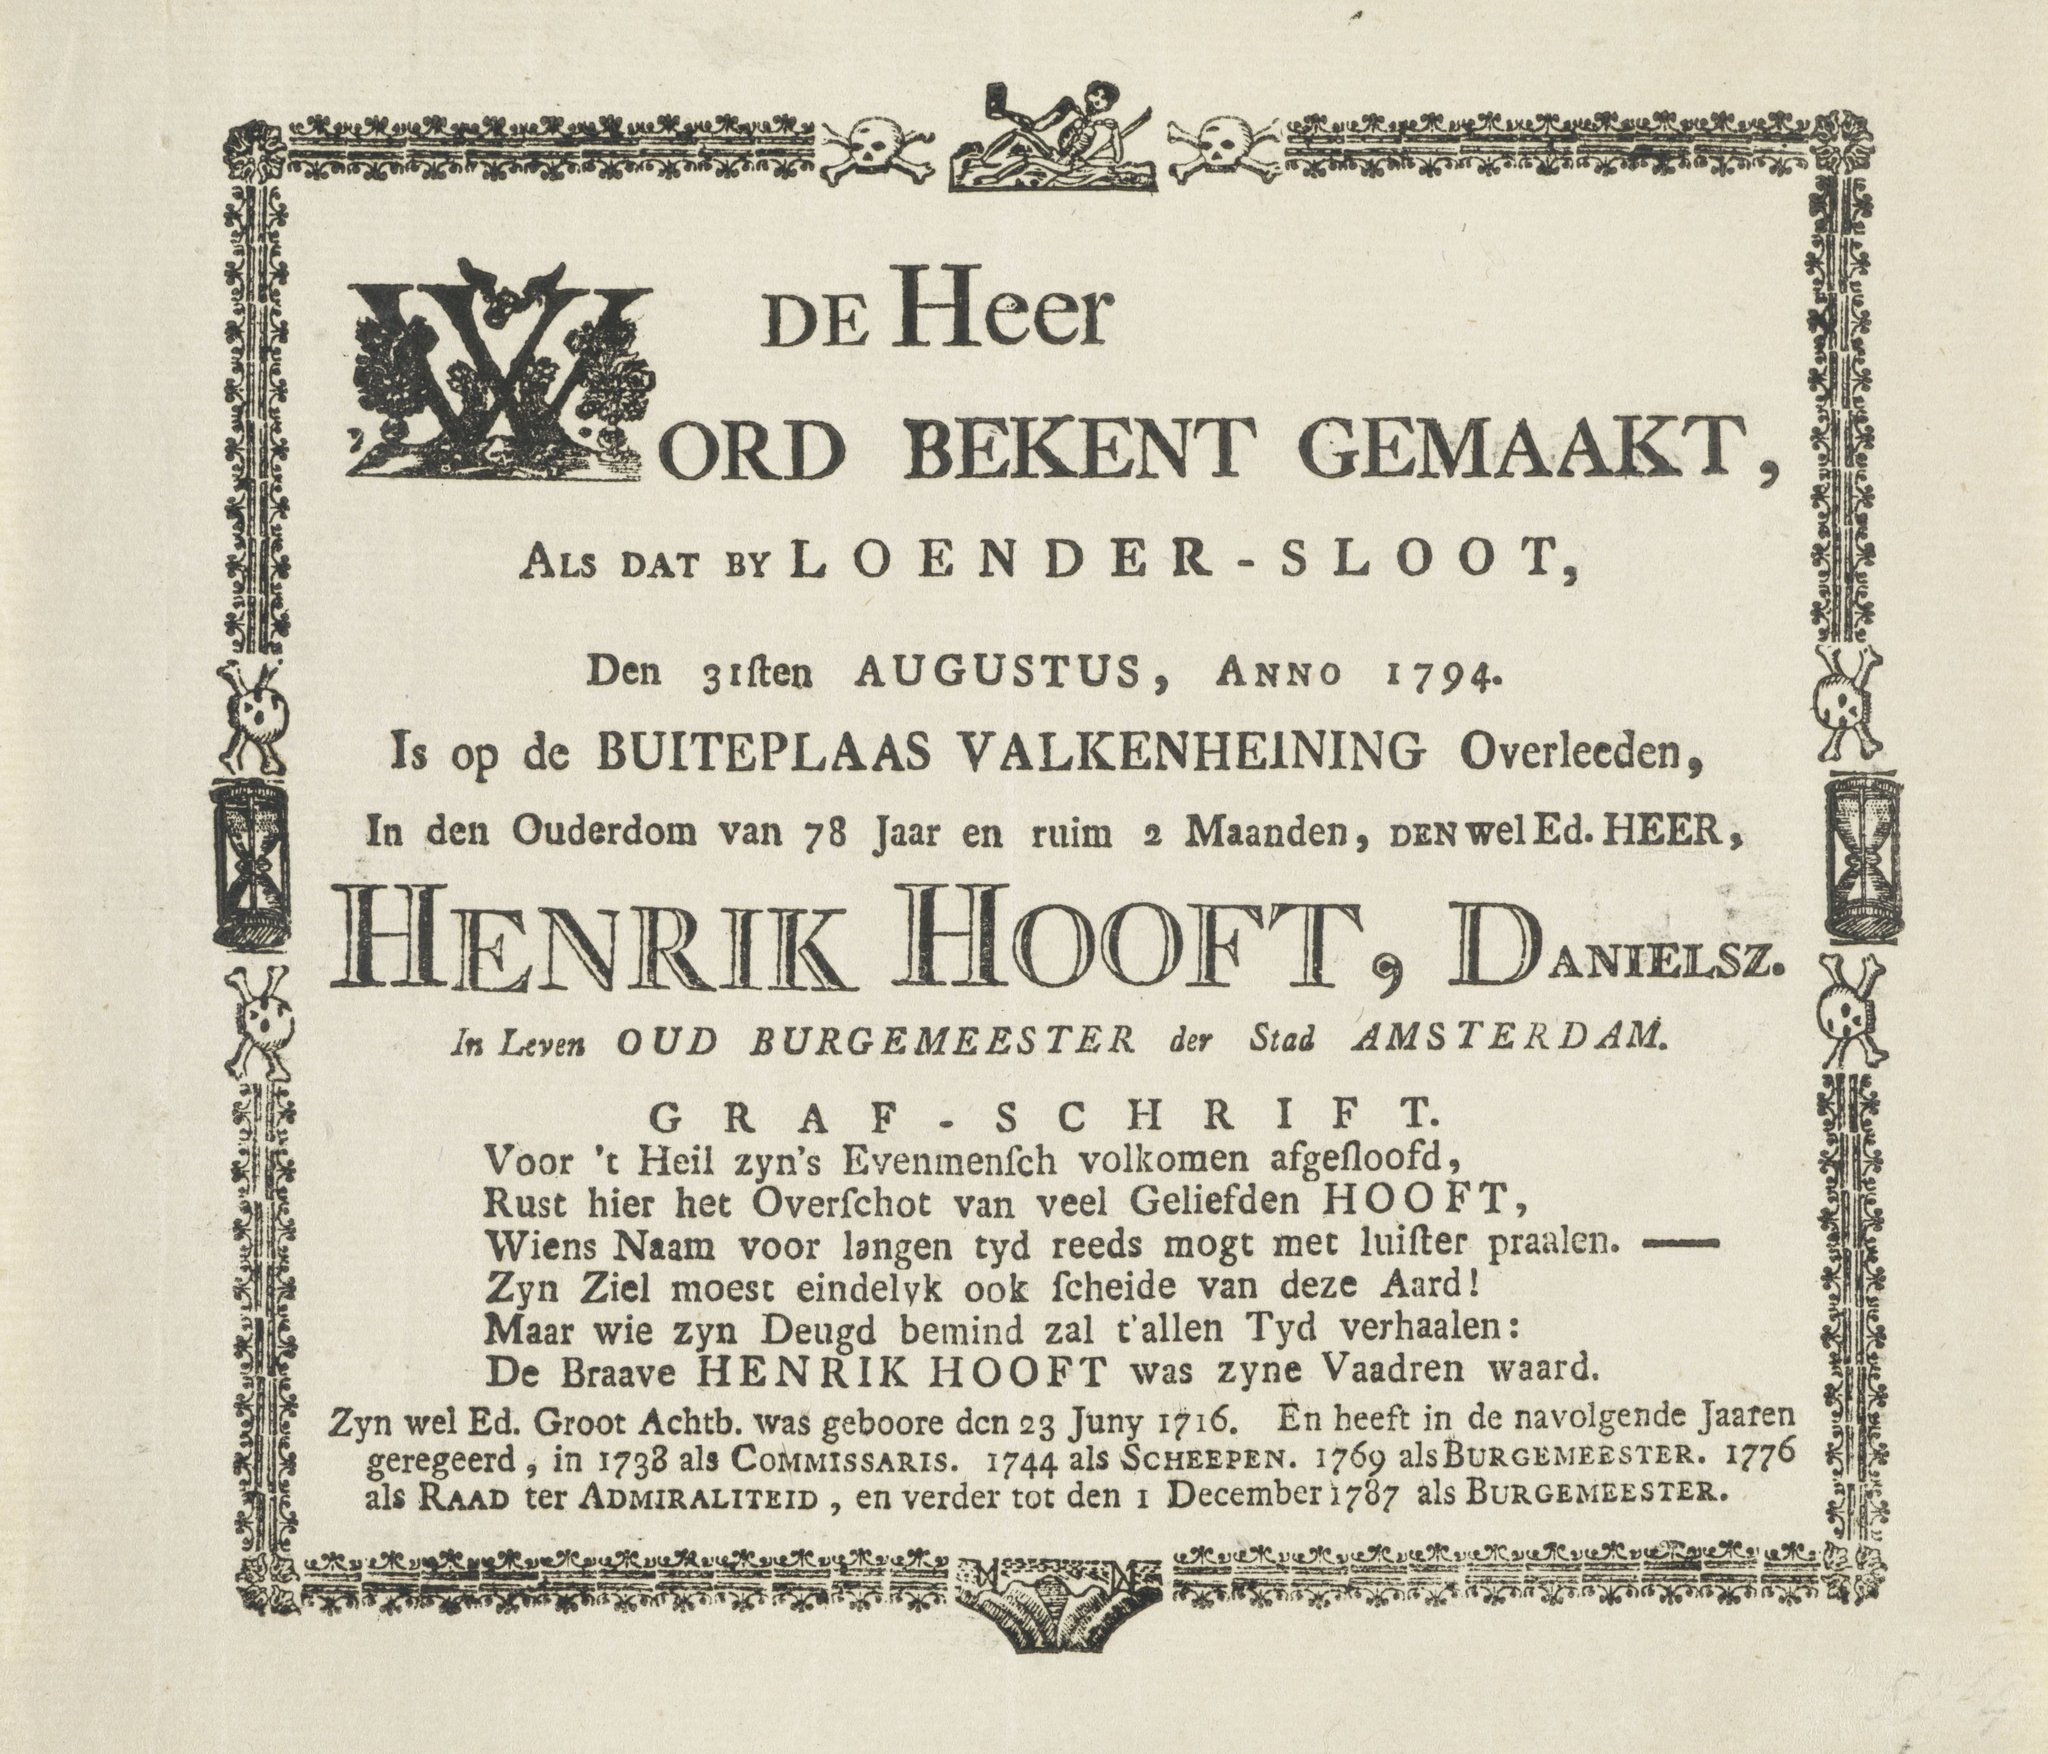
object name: text sheet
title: Bekendmaking van het overlijden van Hendrik Danielsz. Hooft, 1794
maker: Anonymous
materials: paper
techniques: letterpress printing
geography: northern netherlands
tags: mayor, hendrik danielsz. hooft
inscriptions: collector's mark: Lugt 2228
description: Bekendmaking van het overlijden van Hendrik Danielsz. Hooft, oud-burgemeester van Amsterdam, op 31 augustus 1794 op de buitenplaats Valkenheining te Loenersloot. Tekst met een zesregelig vers binnen een versierde rand.